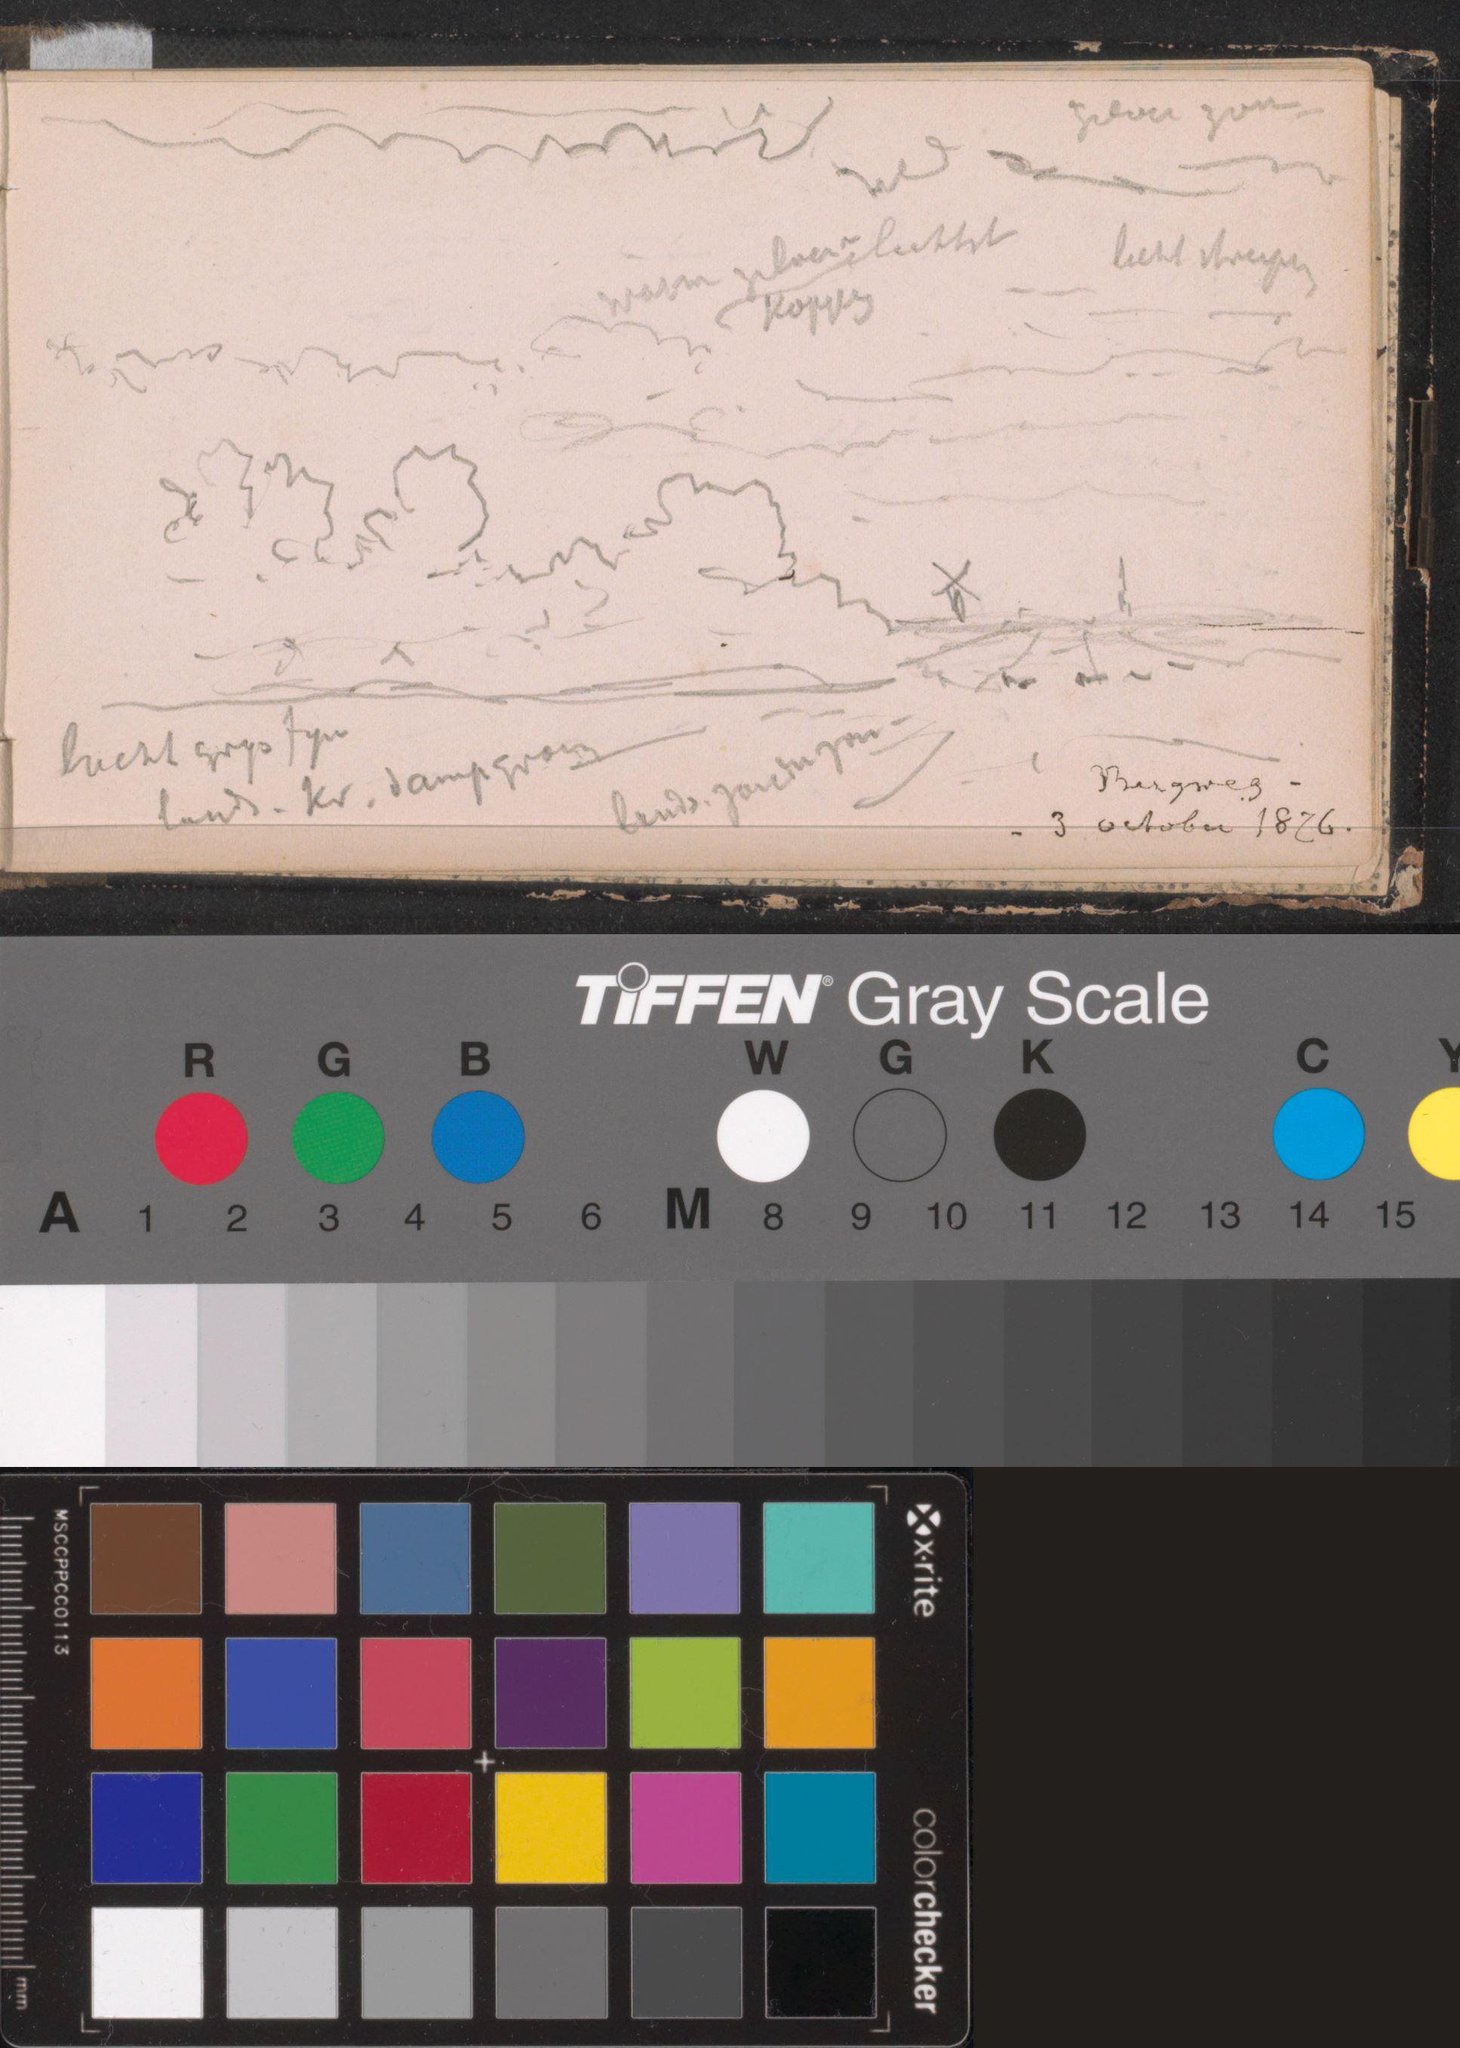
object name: sketchbook leaf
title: Landschap met een molen bij de Bergweg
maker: johannes tavenraat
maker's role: draughtsman, painter, print maker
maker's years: 1809-1881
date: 1810-1876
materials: paper, pencil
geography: rotterdam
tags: windmill in landscape, rotterdam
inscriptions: date and inscription: ‘Bergweg/ 3 october 1876.’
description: Blad 42 recto uit een schetsboek met 46 bladen.